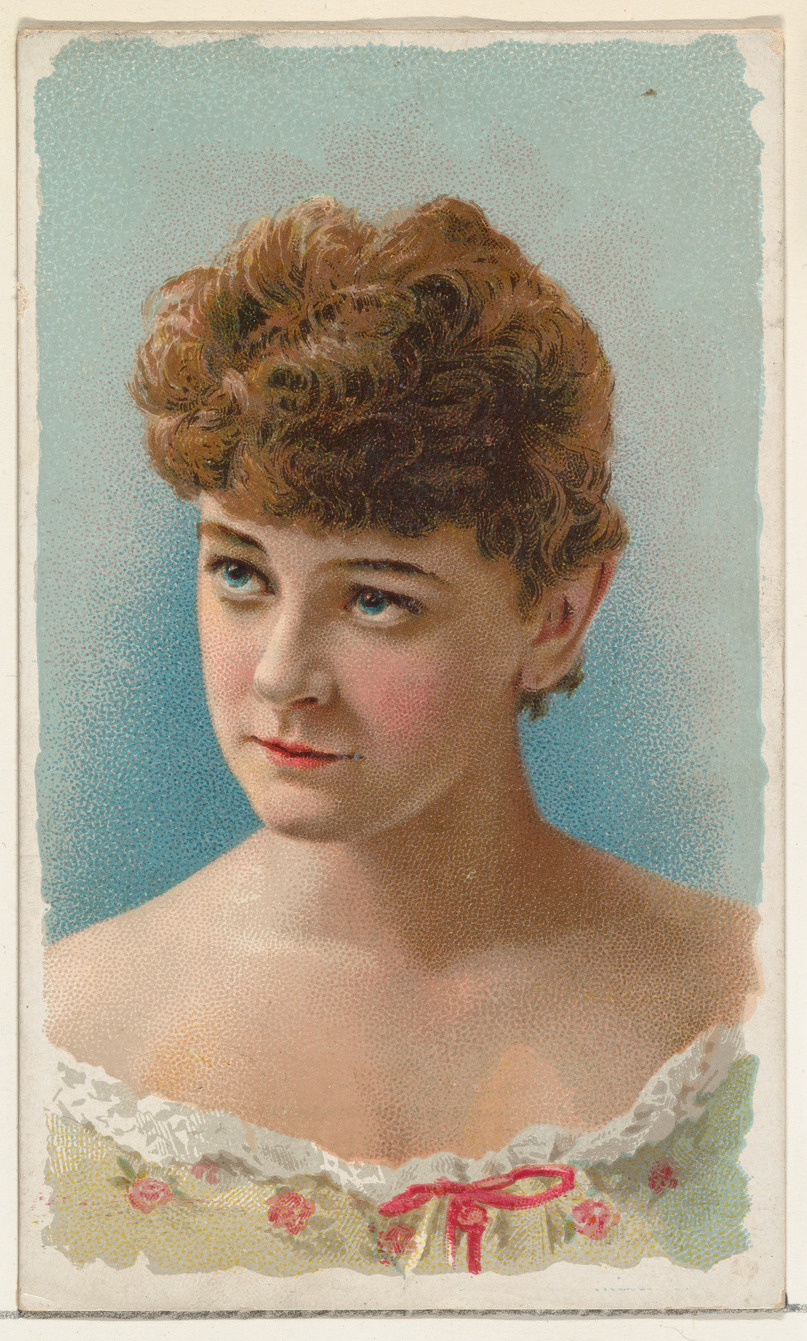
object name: print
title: Actress wearing flowered bodice with pink ribbon bow, from Stars of the Stage, First Series (N129) issued by W. Duke, Sons & Co. to promote Honest Long Cut Tobacco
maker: w. duke, sons & co.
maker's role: publisher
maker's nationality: american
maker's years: 1870-1920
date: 1890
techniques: color lithograph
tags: portraits,women,actresses